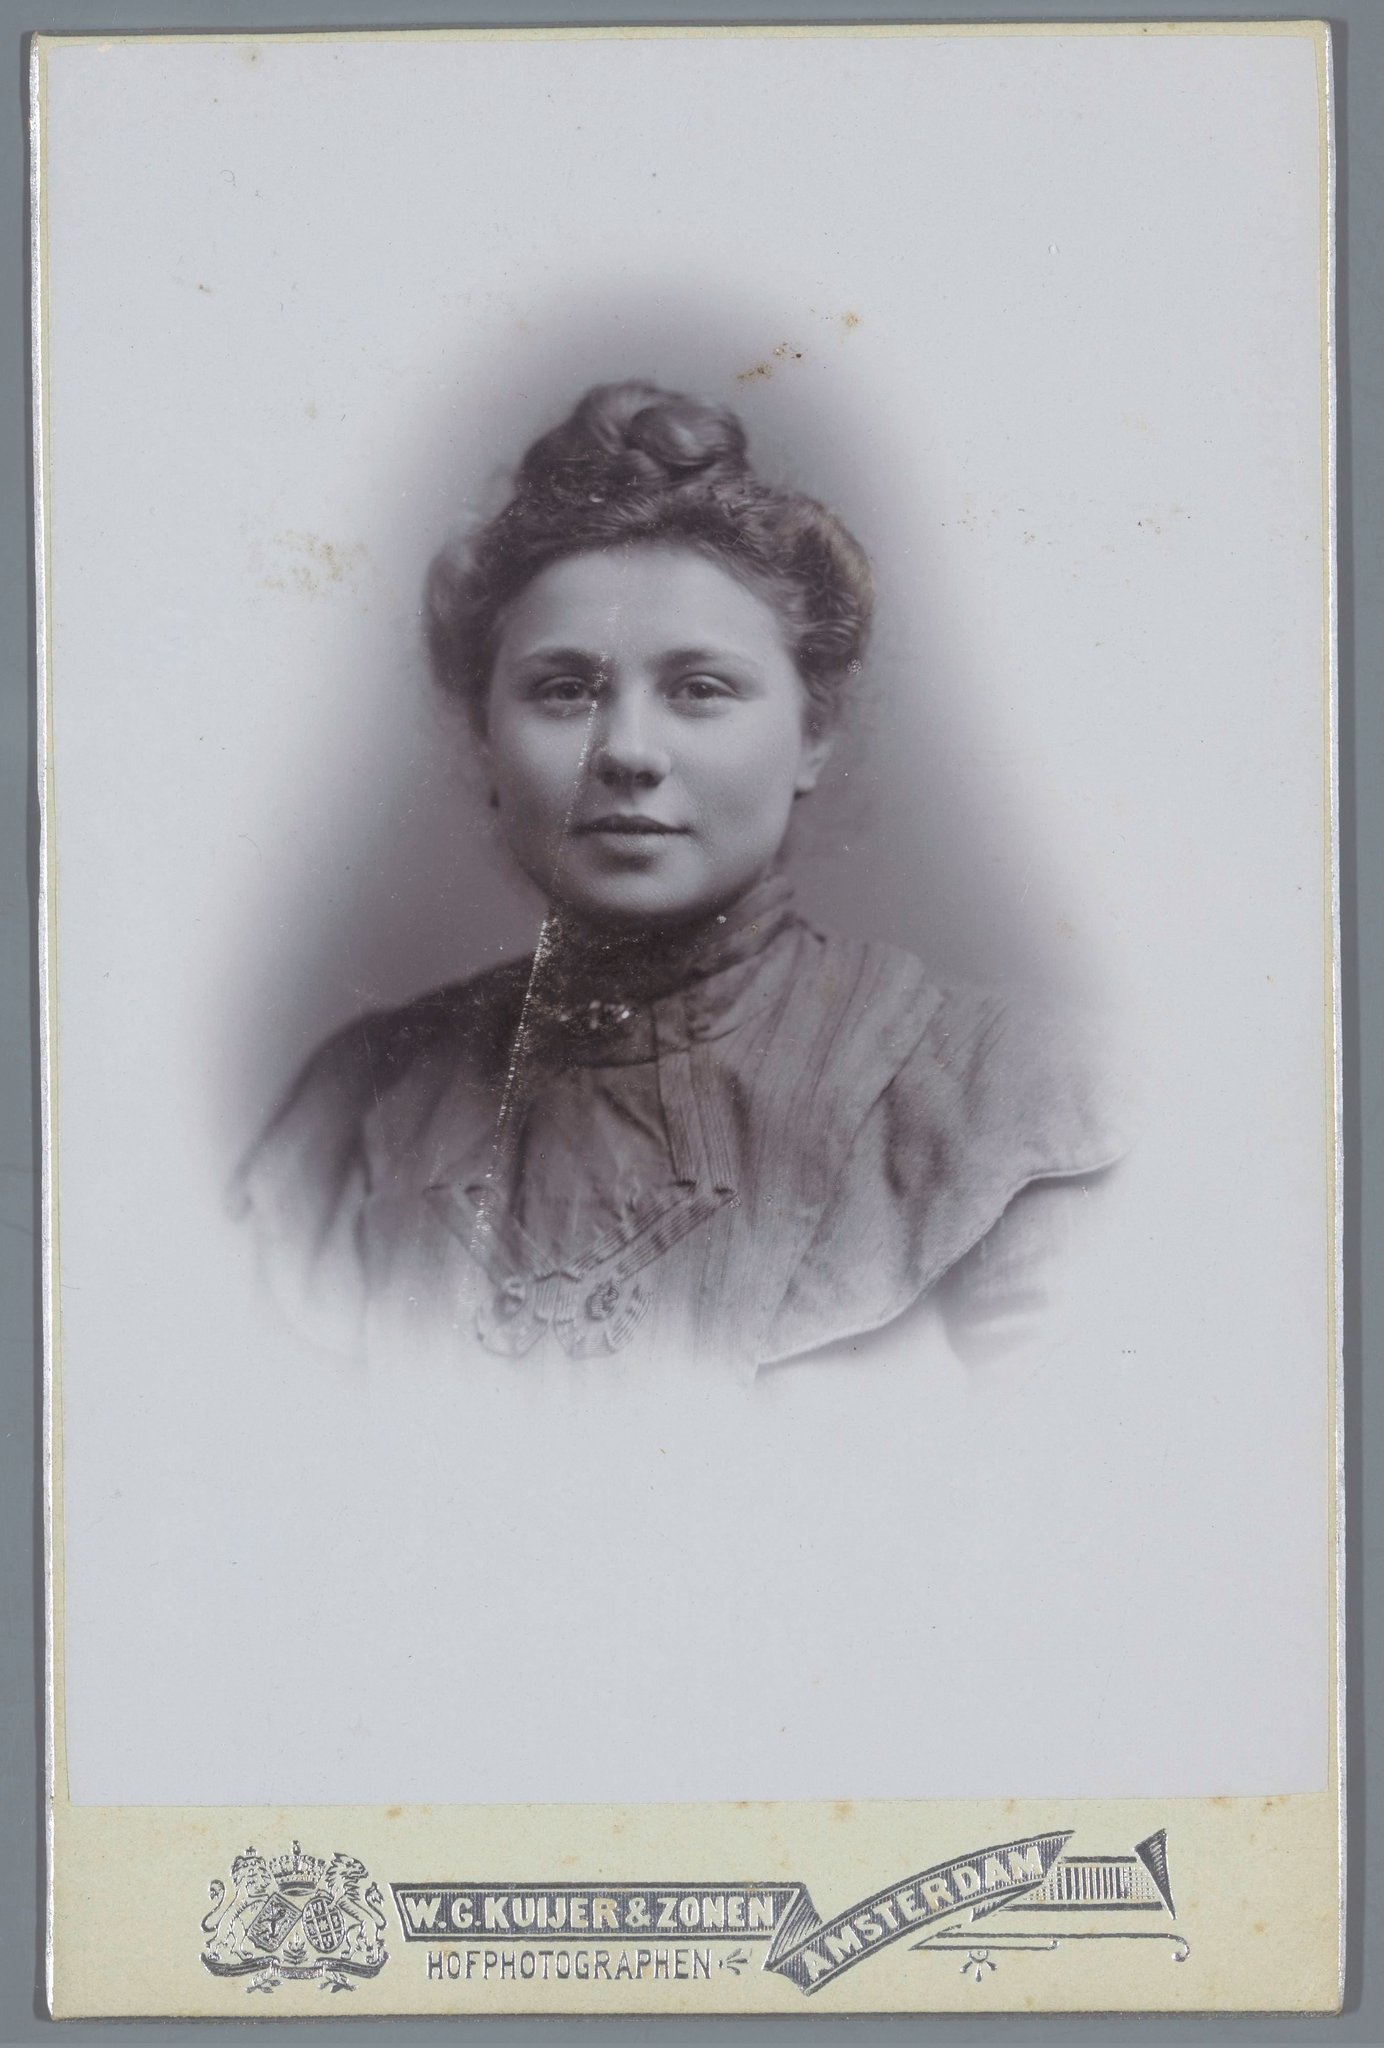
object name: cabinet photograph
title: Portret van mevrouw Jonker-Groenewoud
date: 1890-1910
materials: cardboard, photographic support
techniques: collodion silver print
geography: amsterdam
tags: adult woman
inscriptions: inscription: ‘W.G. Kuijer & Zonen Hofphotographen Amsterdam’, inscription: ‘W.G. Kuijer & Zonen Hofphotographen Westermarkt 19. Amsterdam Spéciale Inrichting voor Vergrootingen in alle Formaten.’